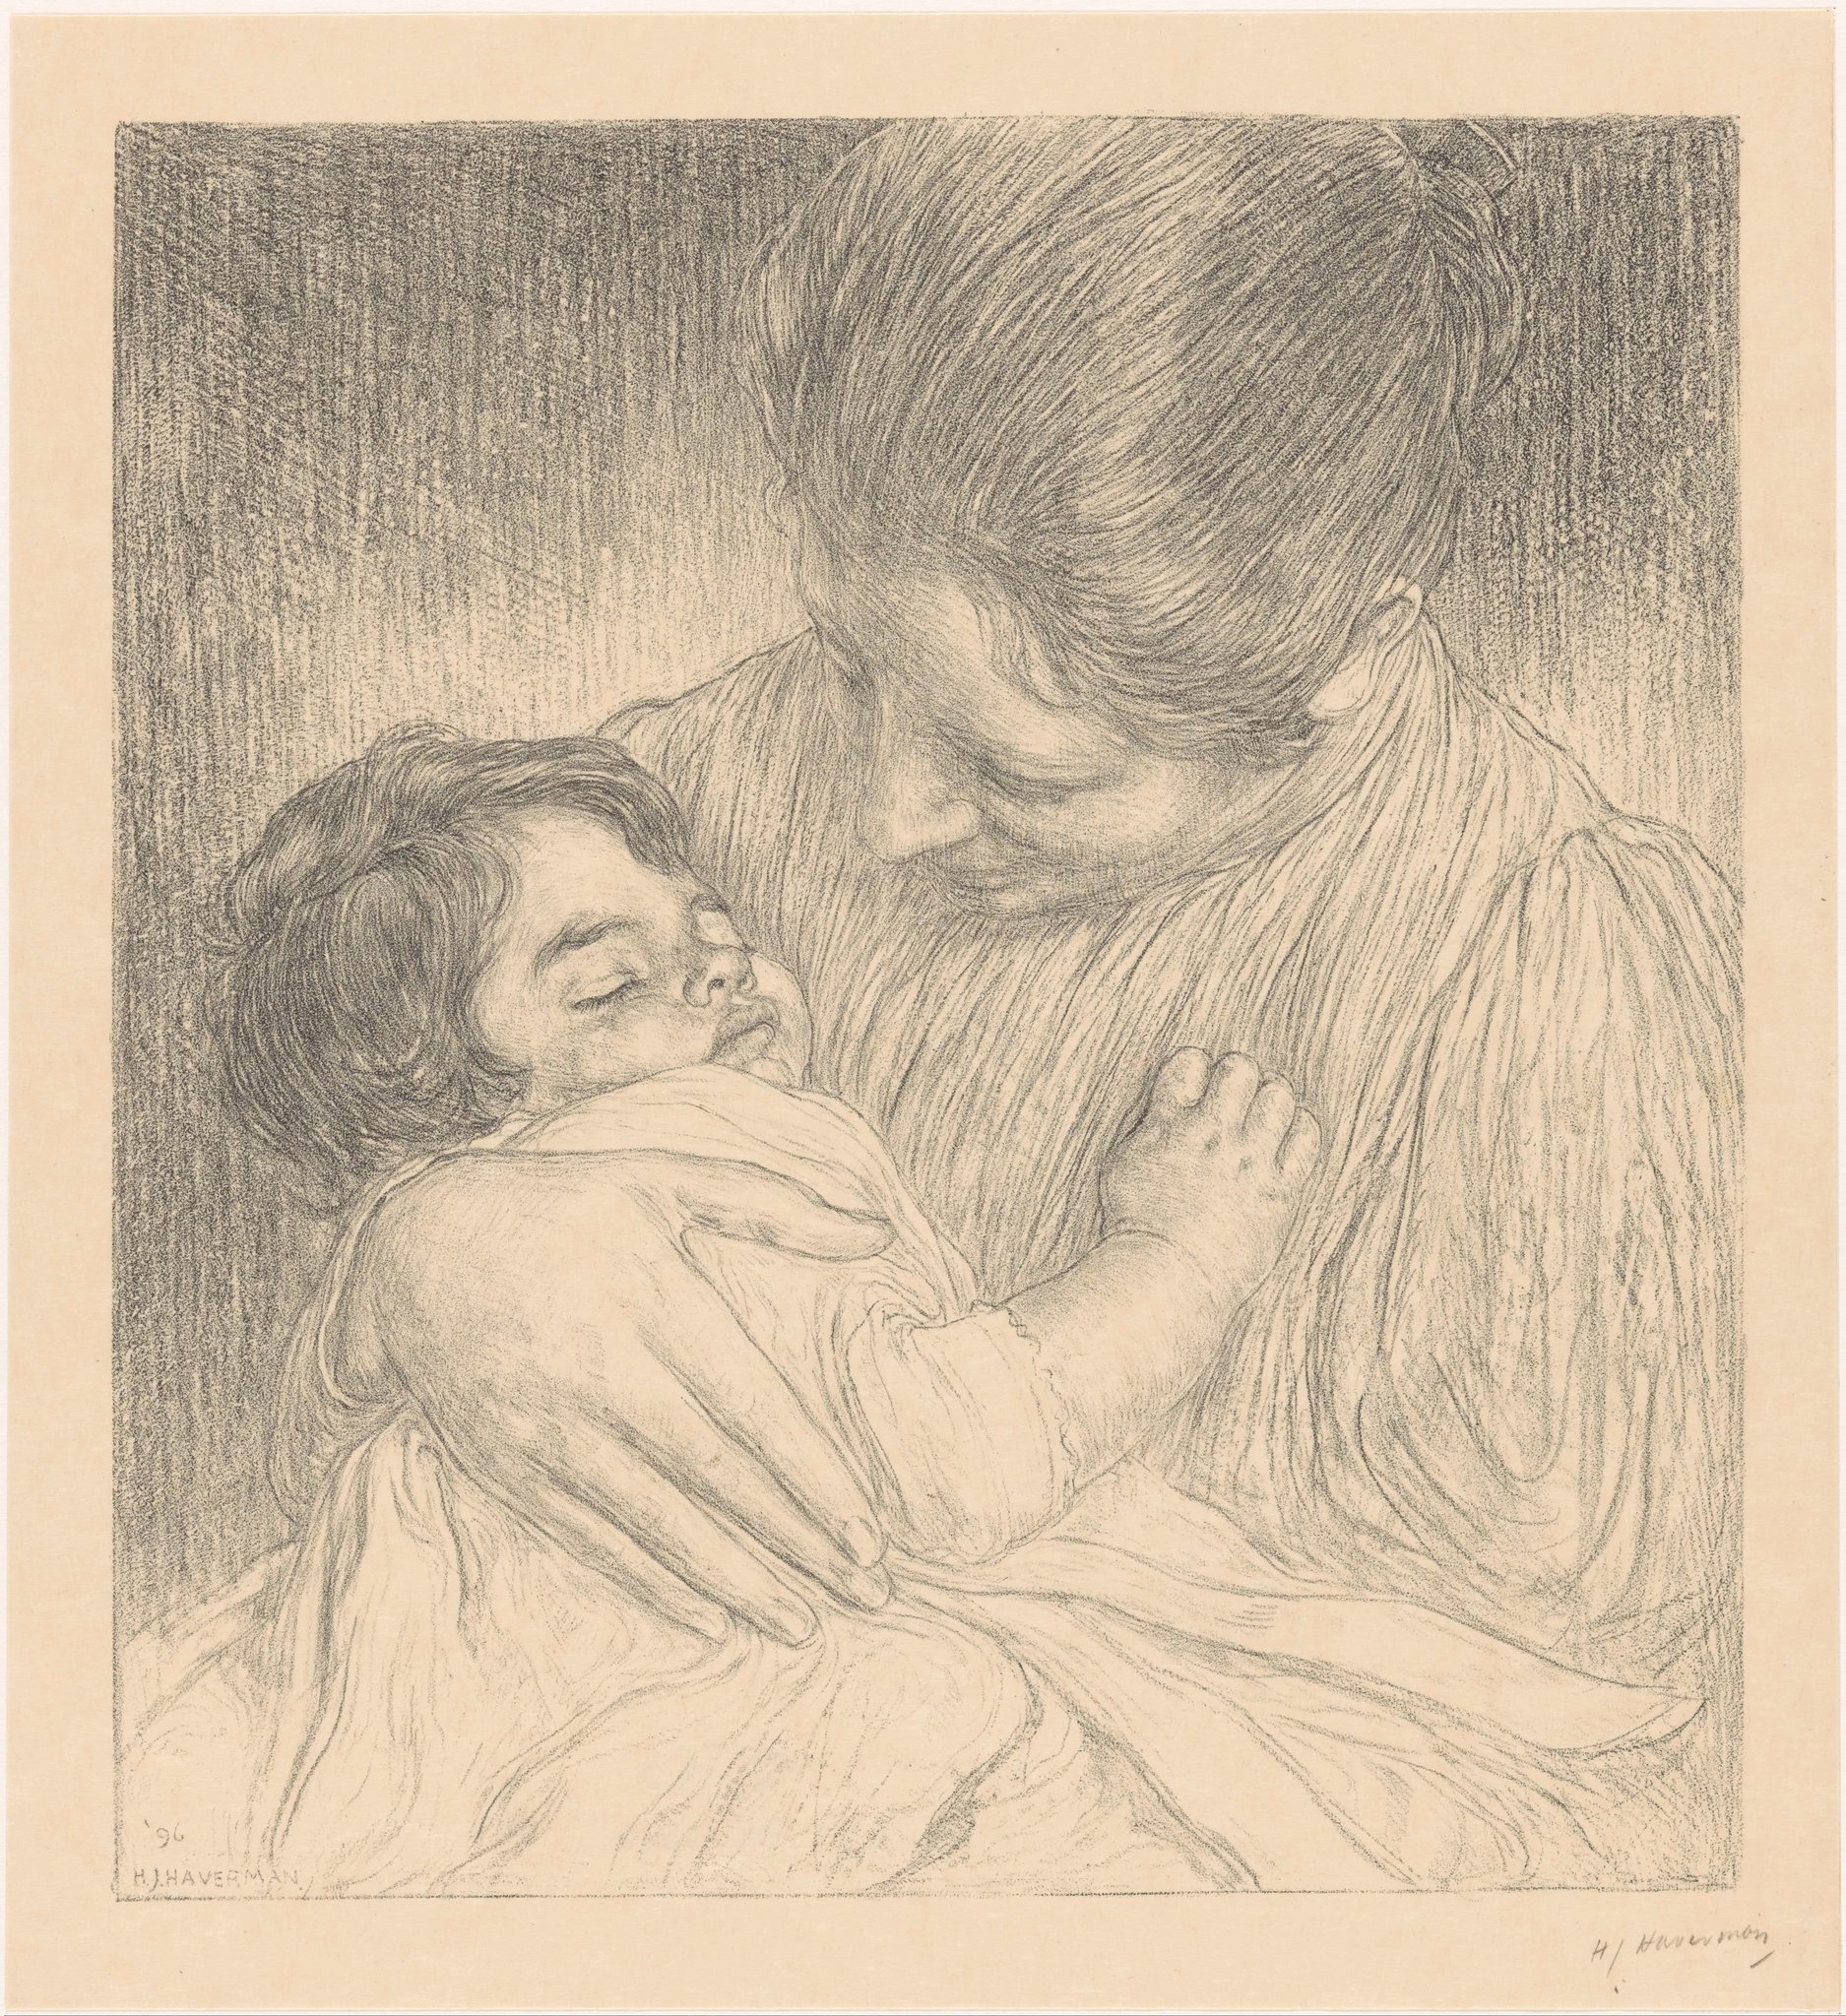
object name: print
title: Avond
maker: hendrik johannes haverman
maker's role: draughtsman, print maker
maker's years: 1857-1928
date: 1896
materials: paper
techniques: lithograph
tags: mother and child(ren), woman and child(ren) (family group)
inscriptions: collector's mark: Lugt 2228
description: Een vrouw met een slapend kind in haar armen.